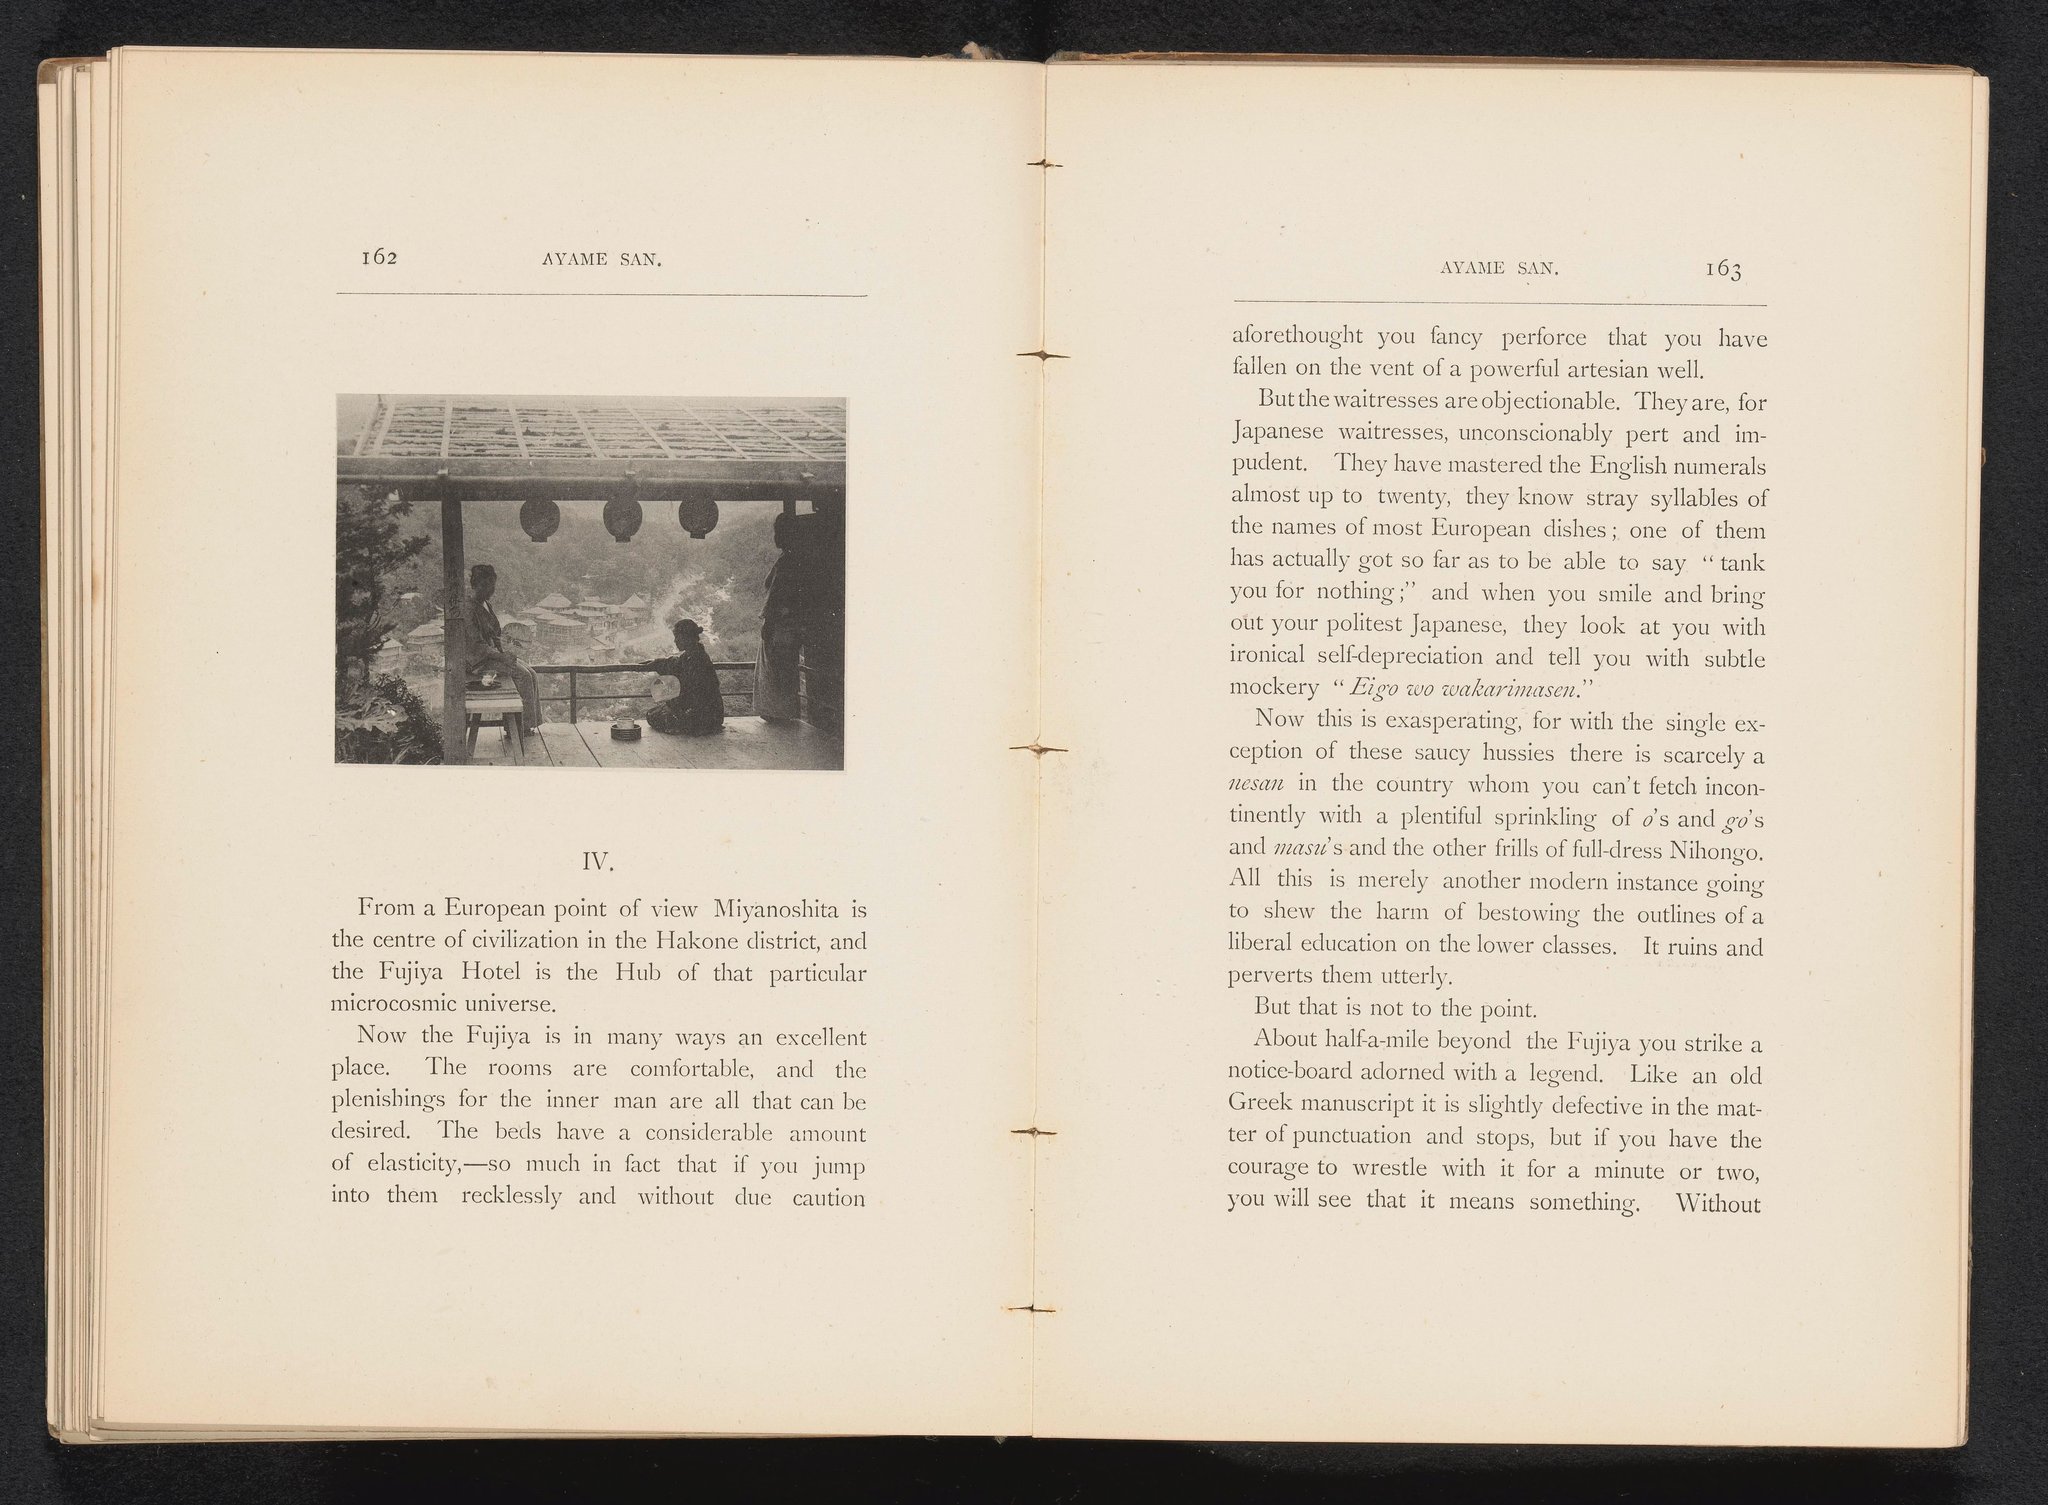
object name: photomechanical print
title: Drie vrouwen in een prieel op een heuvel te Japan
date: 1882-1892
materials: paper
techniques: photograph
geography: japan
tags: (high) hill, summer-house, arbour, garden-house (dutch: 'theekoepel')